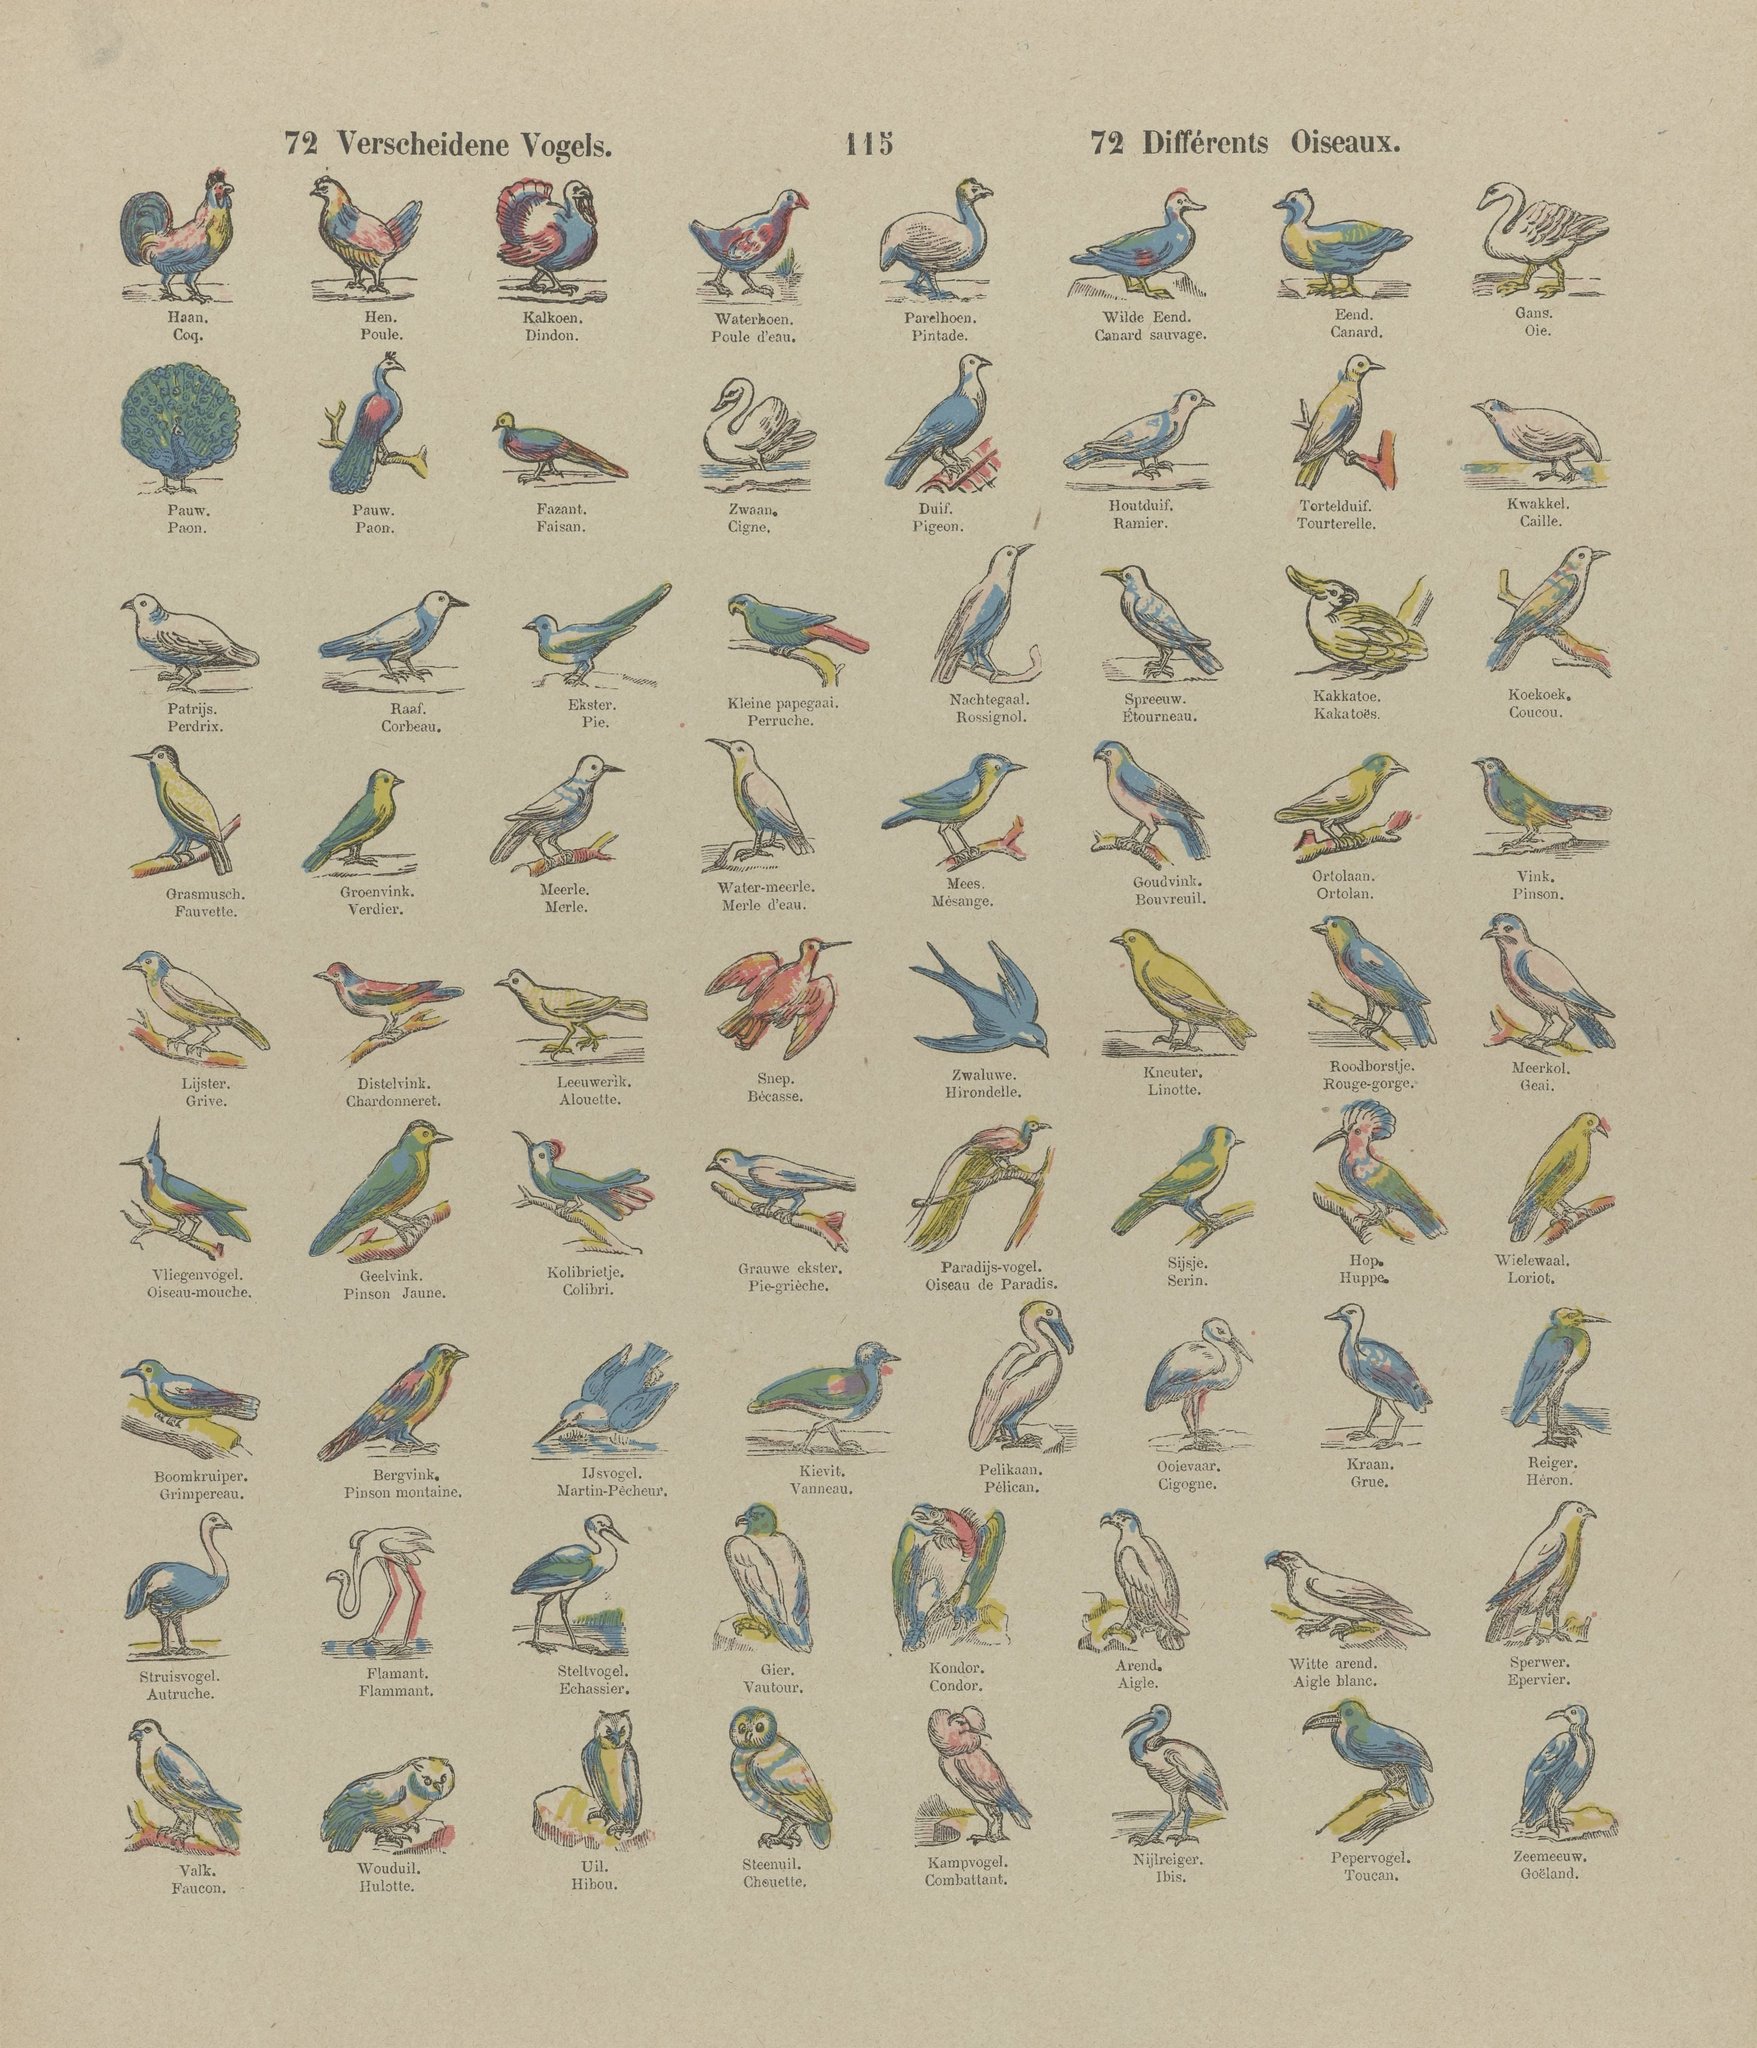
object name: popular print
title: 72 Verscheidene vogels / 72 Différents oiseaux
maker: Anonymous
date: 1833-1911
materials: paper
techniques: colour, letterpress printing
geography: turnhout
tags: birds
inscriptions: collector's mark: Lugt 2760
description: Blad met 72 voorstellingen van vogels. Onder elke voorstelling de naam van de vogel in het Nederlands en in het Frans. Genummerd midden boven: 115.